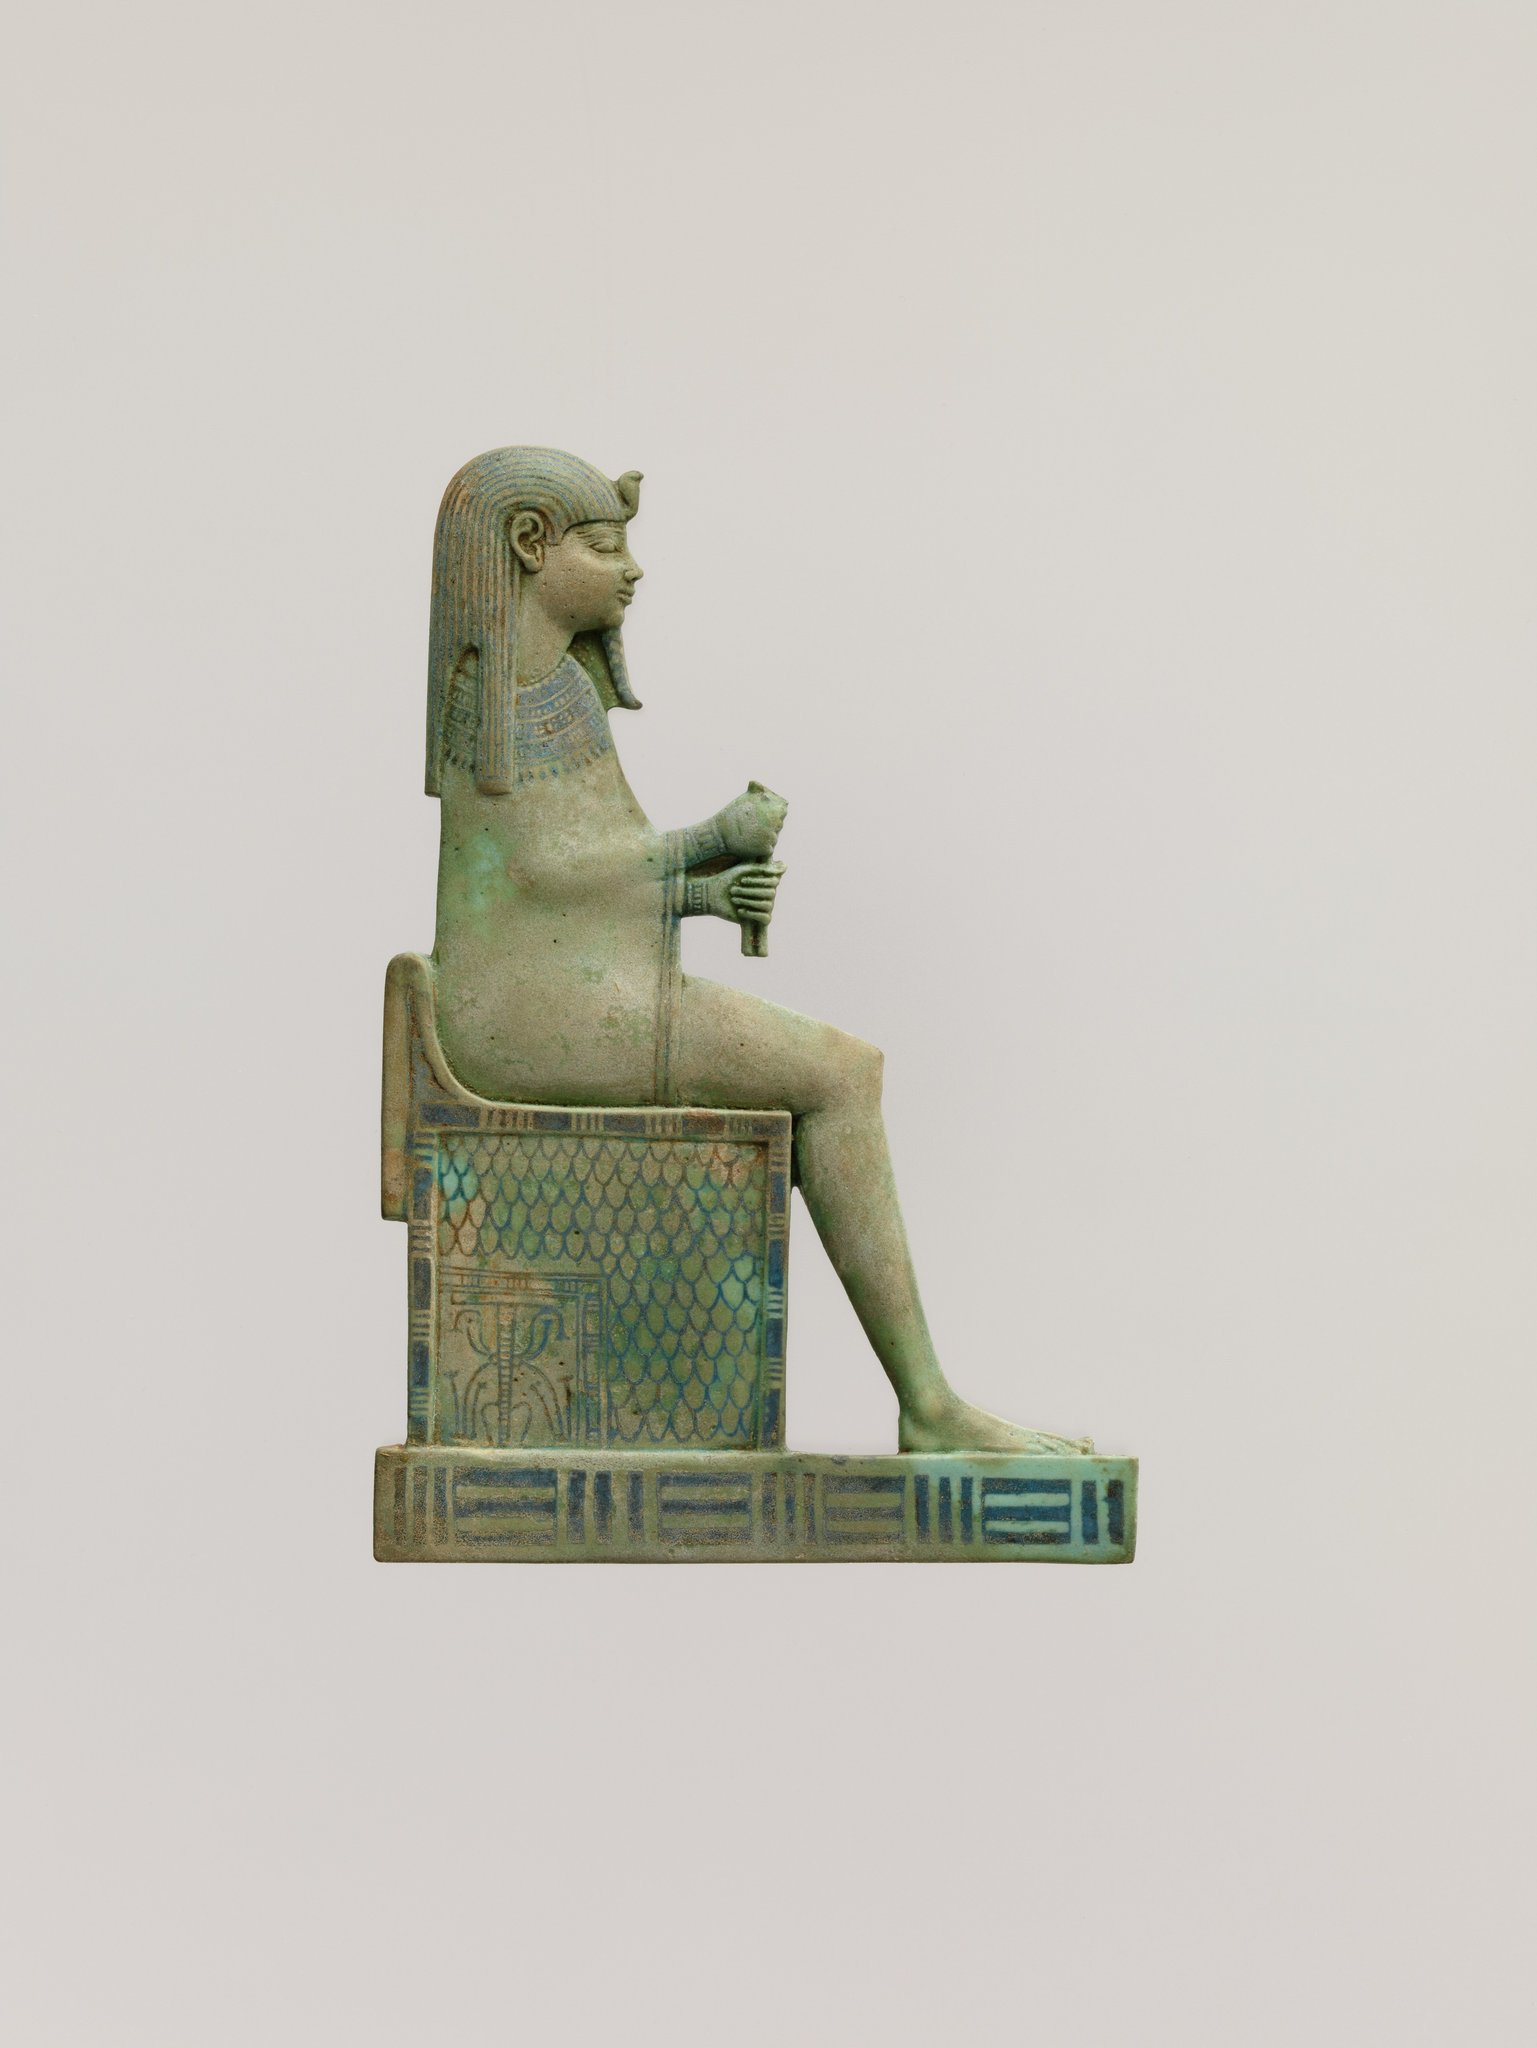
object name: inlay, god shepsi, throne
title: Inlay depicting enthroned god Shepsi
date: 400-301 BCE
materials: faience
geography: middle egypt